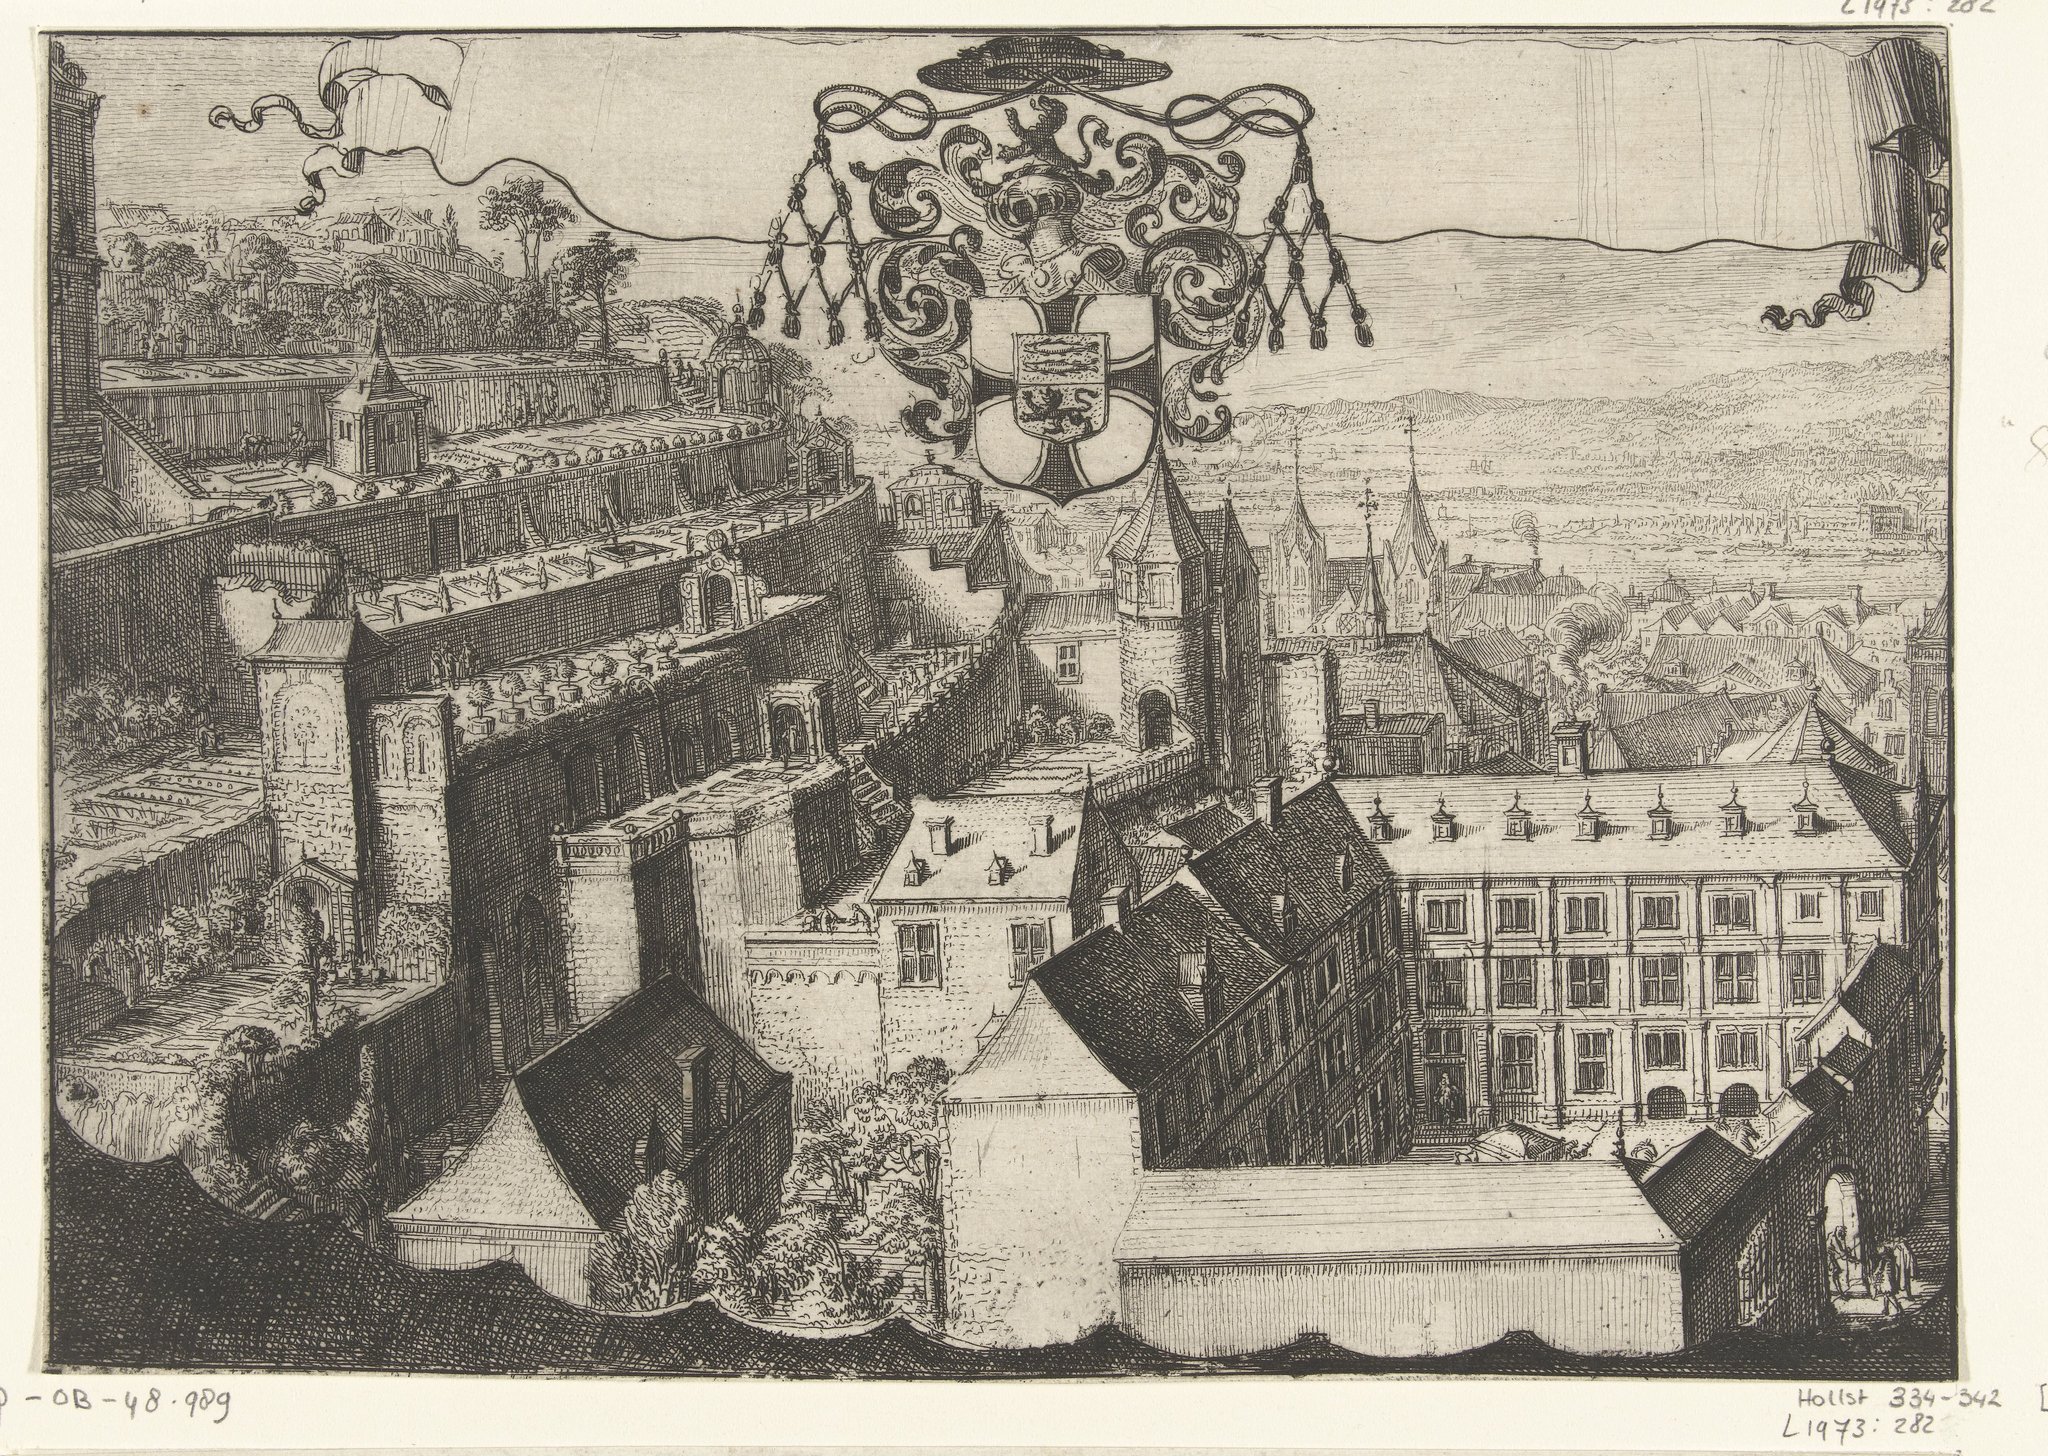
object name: print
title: Gezicht op kasteel Sint-André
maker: romeyn de hooghe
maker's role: draughtsman, goldsmith, painter, print maker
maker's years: 1645-1708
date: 1700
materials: paper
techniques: etching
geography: haarlem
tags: castle, military orders, e.g.: knights templars, knights of malta, teutonic knights ~ roman catholic church, armorial bearing, heraldry, liège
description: Gezicht op kasteel Sint-André bij Luik. Bovenin de voorstelling een banderol zonder tekst en een wapen. Deze prent maakt deel uit van een omvangrijke voorstelling, samengesteld uit 20 afzonderlijke platen, van de geschiedenis en de werken van de Duitse Orde (midden) omgeven door voorstellingen van de landcommanderij Alden Biesen (onderaan) en de daarbij behorende commanderijen (links en rechts).